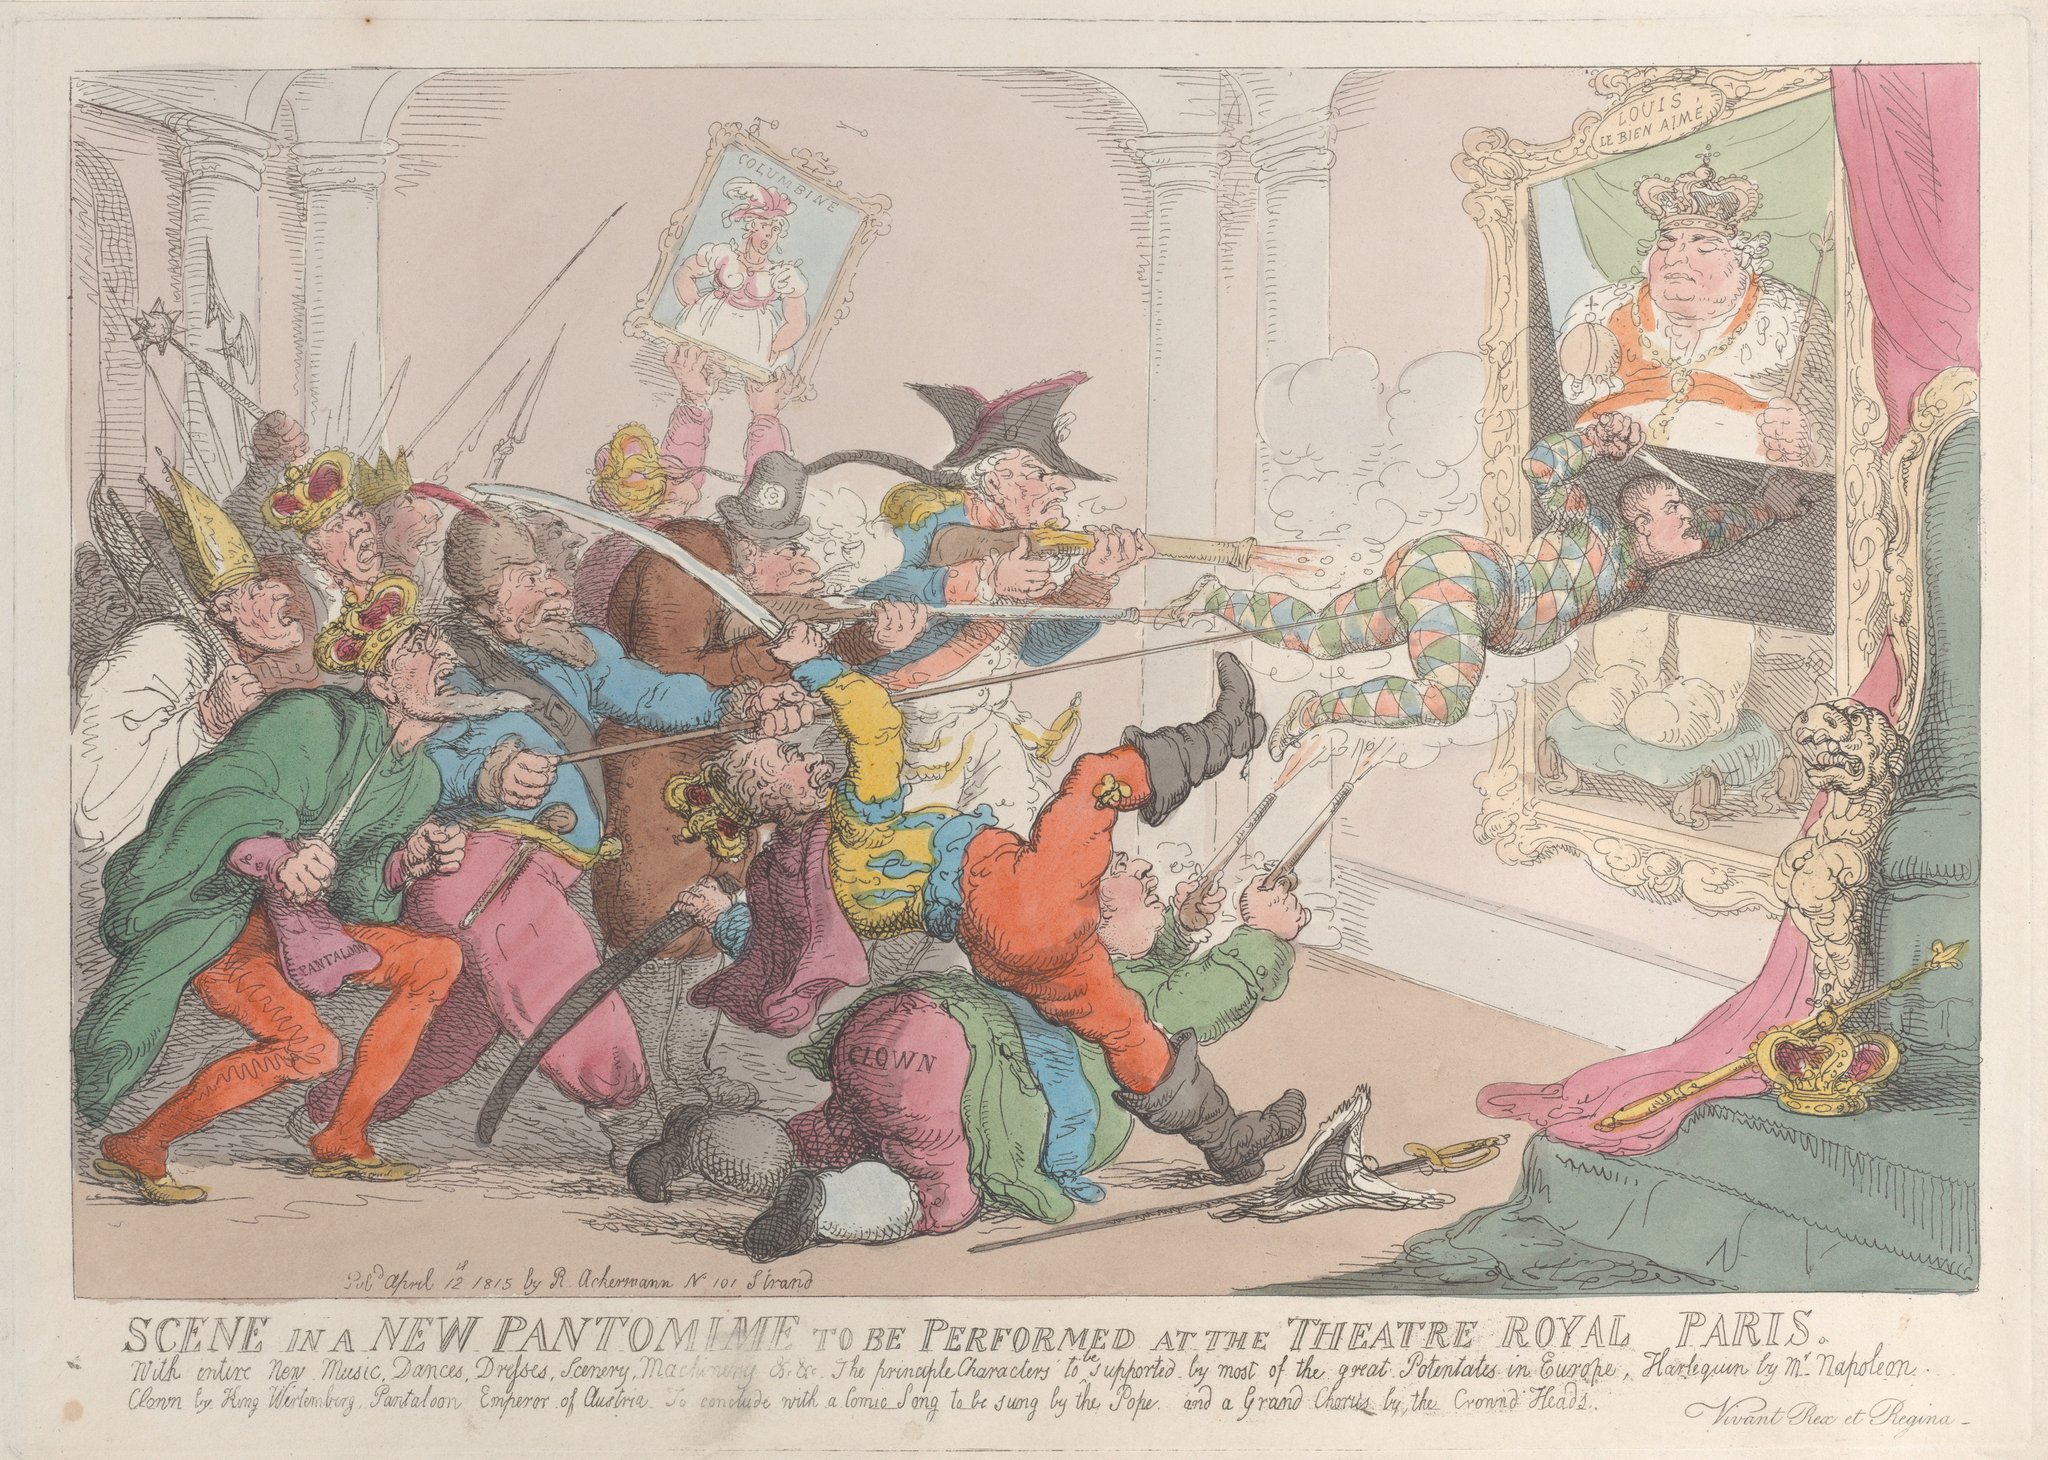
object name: print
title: Scene in a New Pantomime to be Performed at the Theatre Royal Paris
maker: thomas rowlandson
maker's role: artist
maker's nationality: british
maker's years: 1757-1827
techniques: etching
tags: satire,napoleon i,men,politics